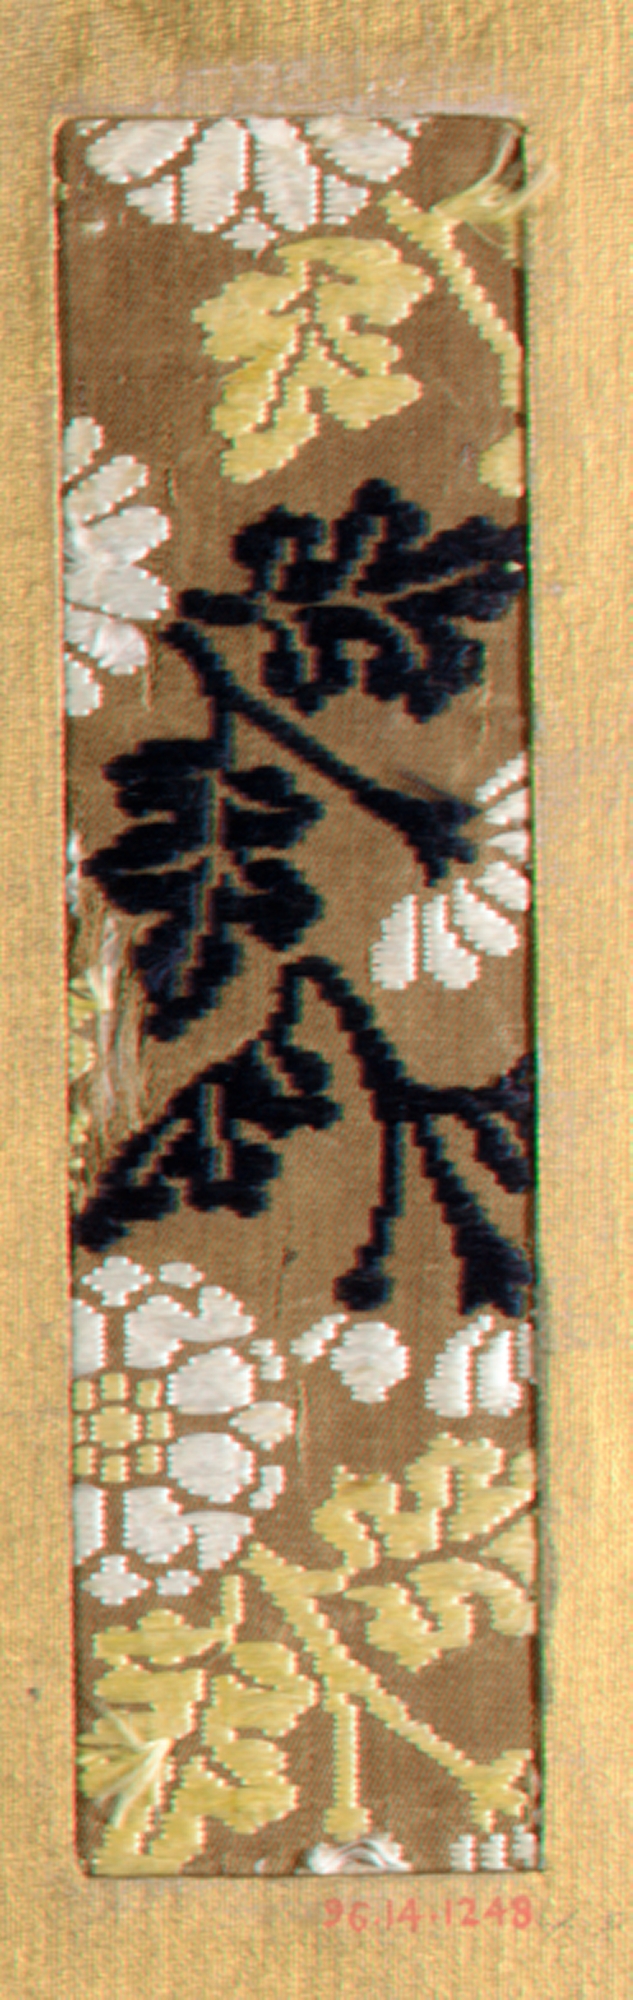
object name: piece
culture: japanese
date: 1701-1900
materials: silk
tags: leaves